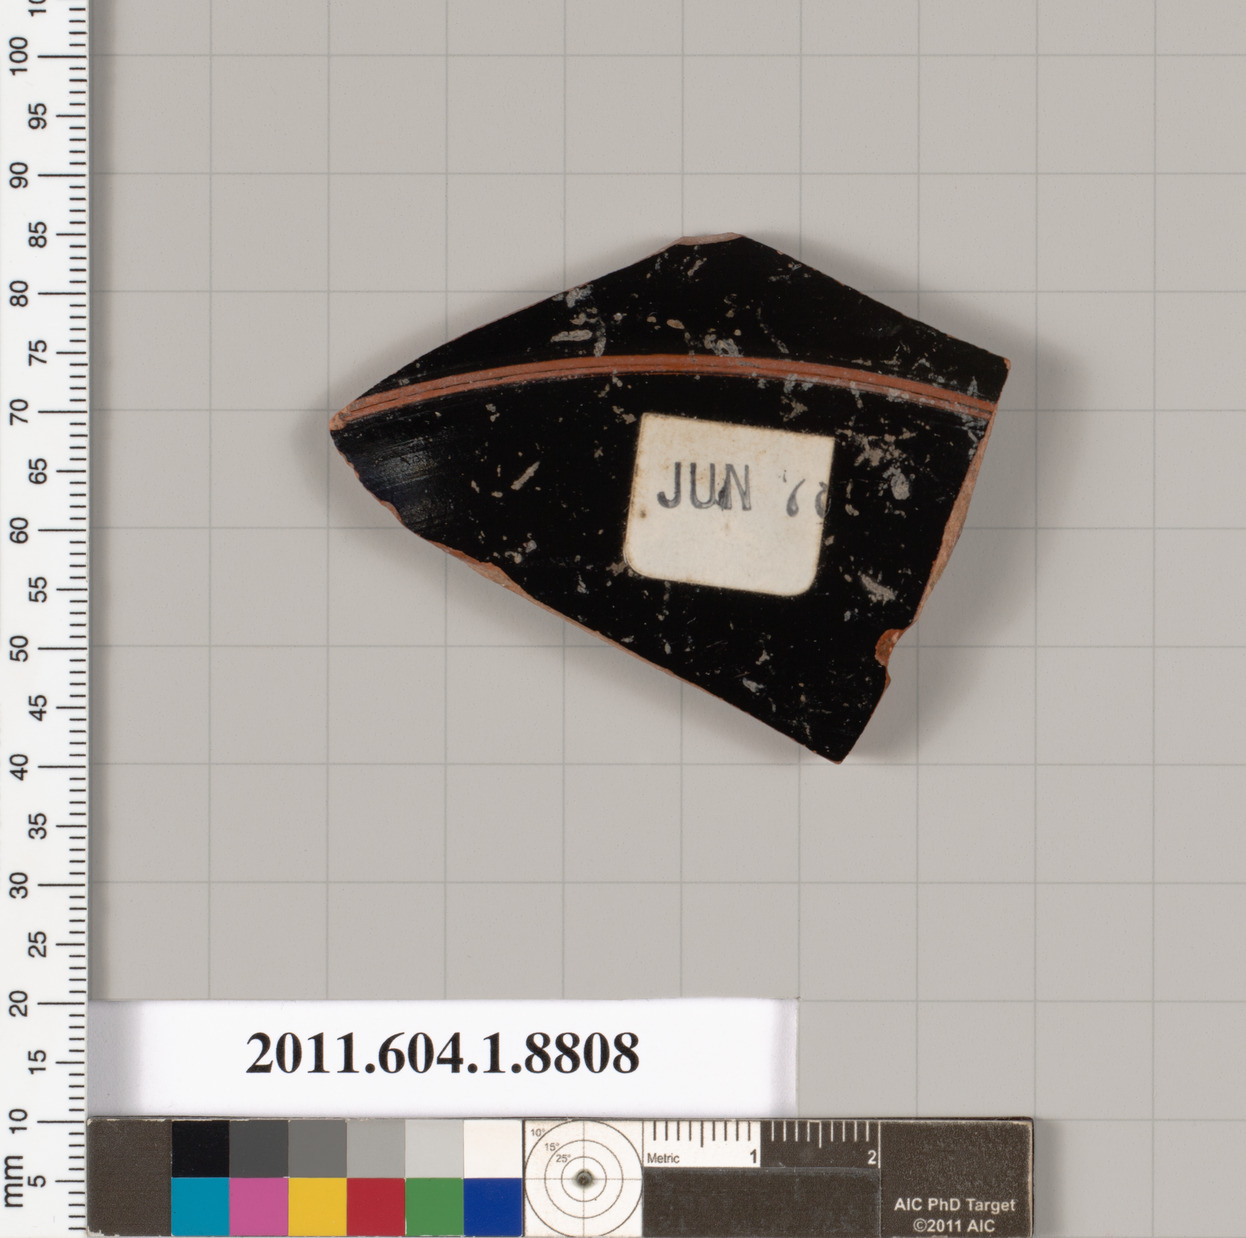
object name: kylix fragment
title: Terracotta fragment of a kylix (cup)?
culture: greek, attic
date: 600-401 BCE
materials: terracotta